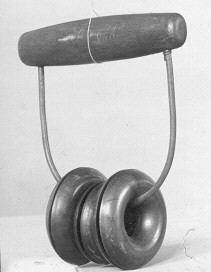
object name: kajirei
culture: japanese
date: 1801-1900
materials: metal, wood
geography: japan